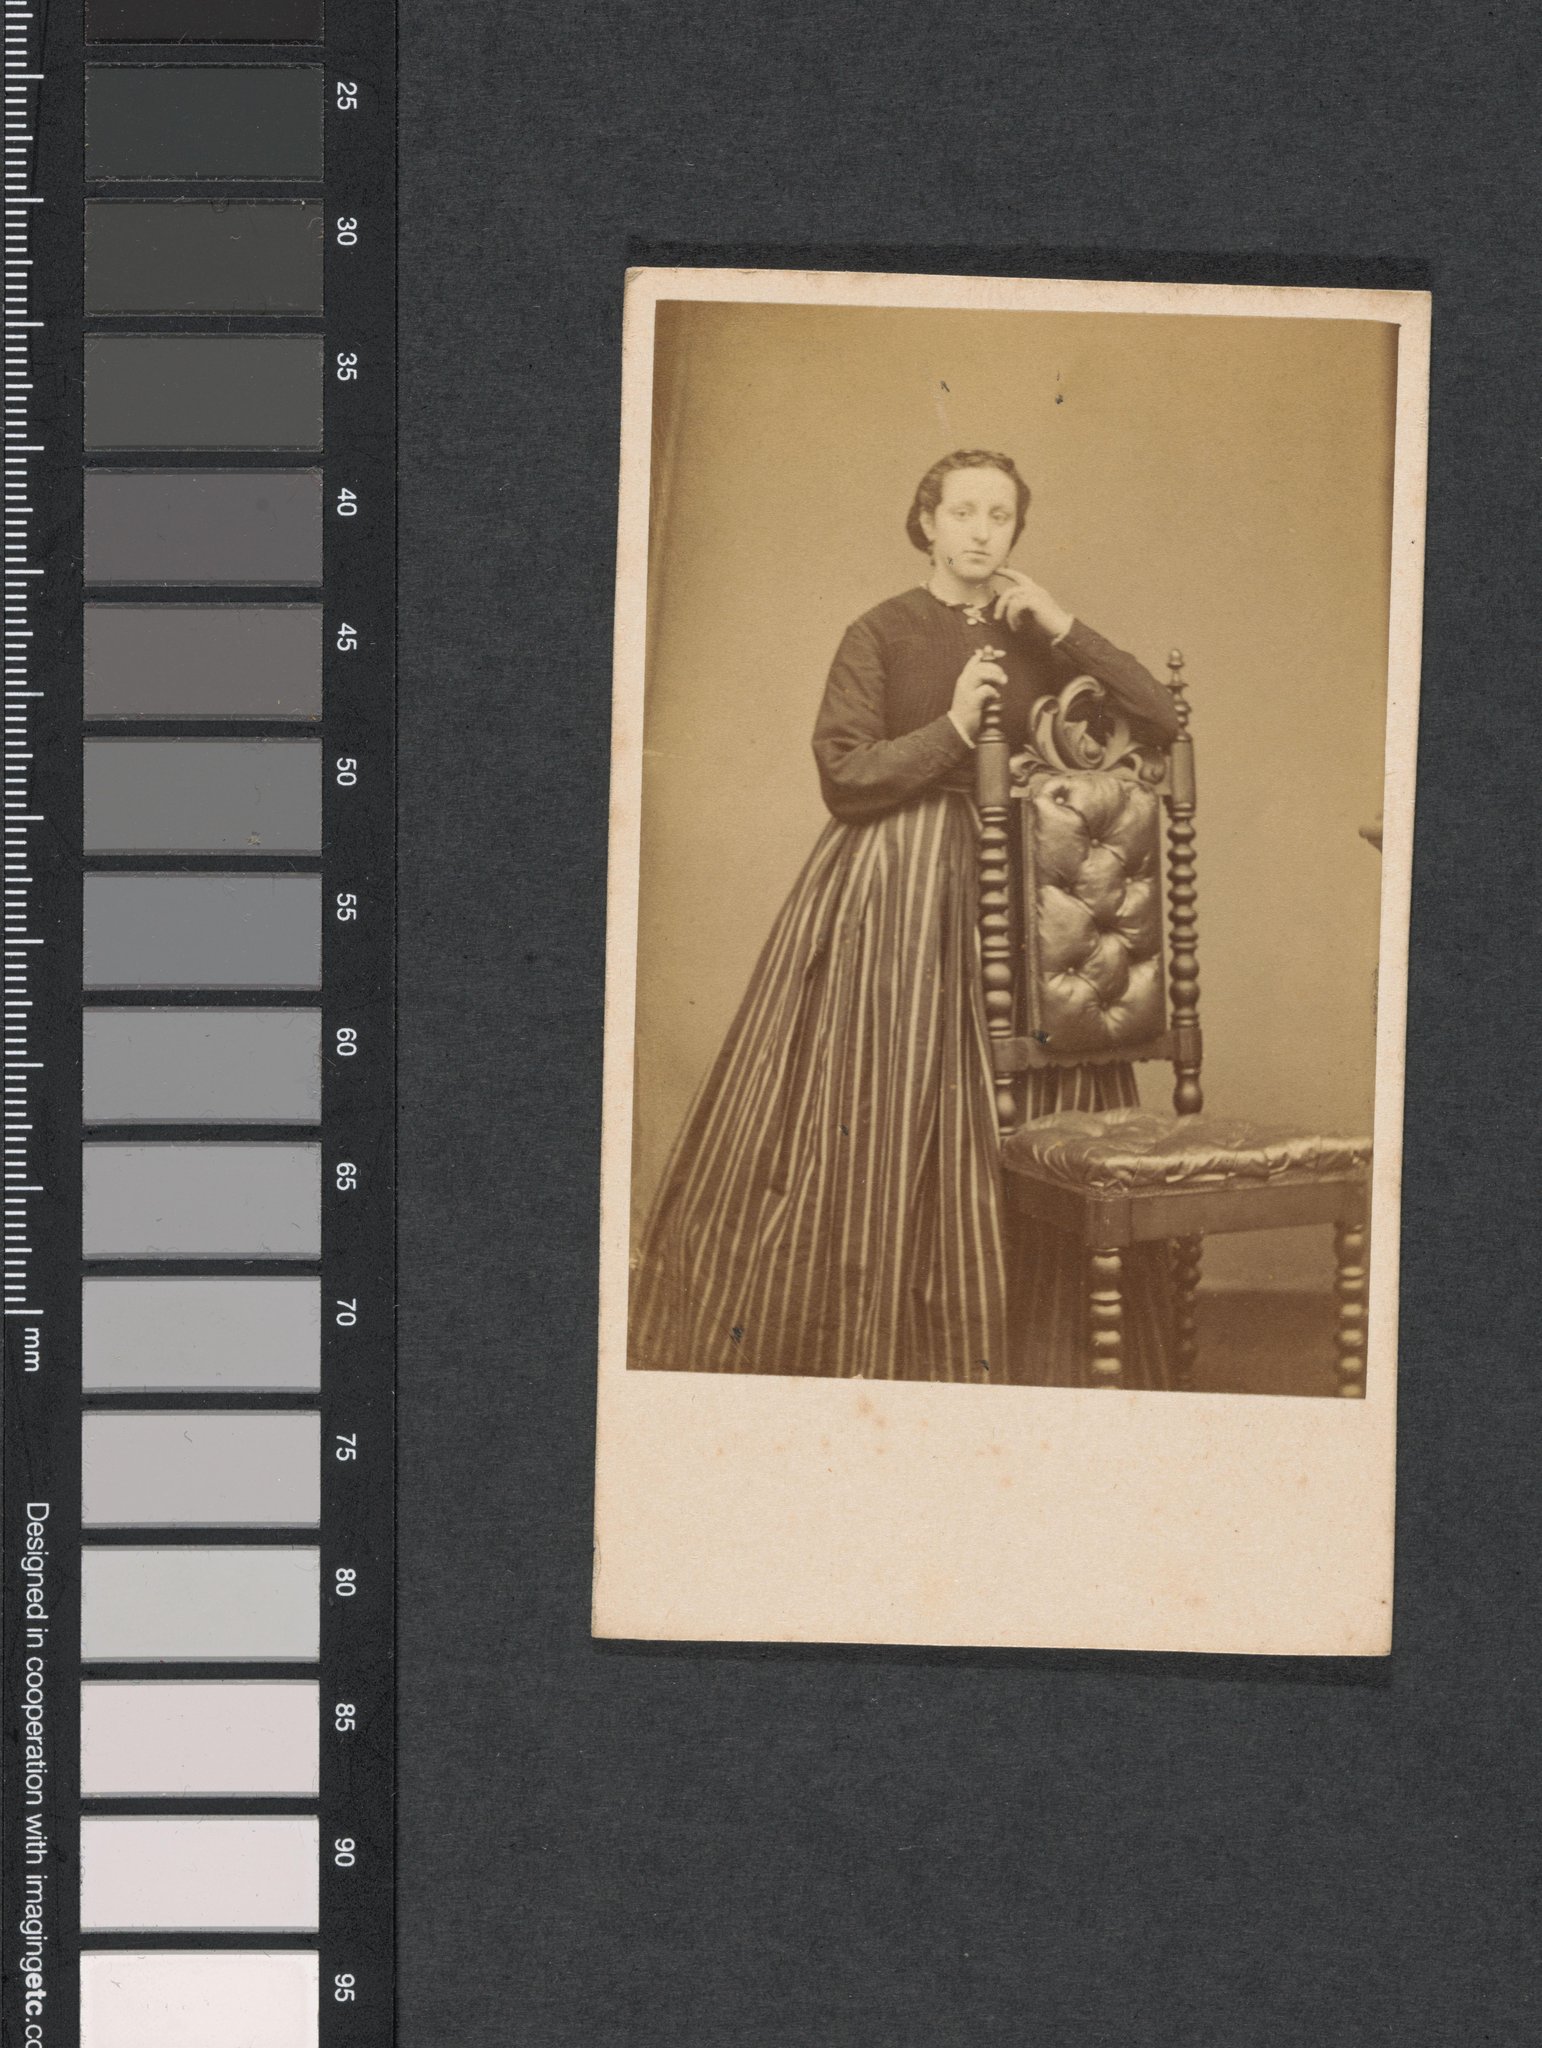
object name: photograph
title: Portret van een onbekende vrouw uit de familie Marmelstein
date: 1850-1900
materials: cardboard, photographic support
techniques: albumen print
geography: amsterdam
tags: adult woman, historical persons